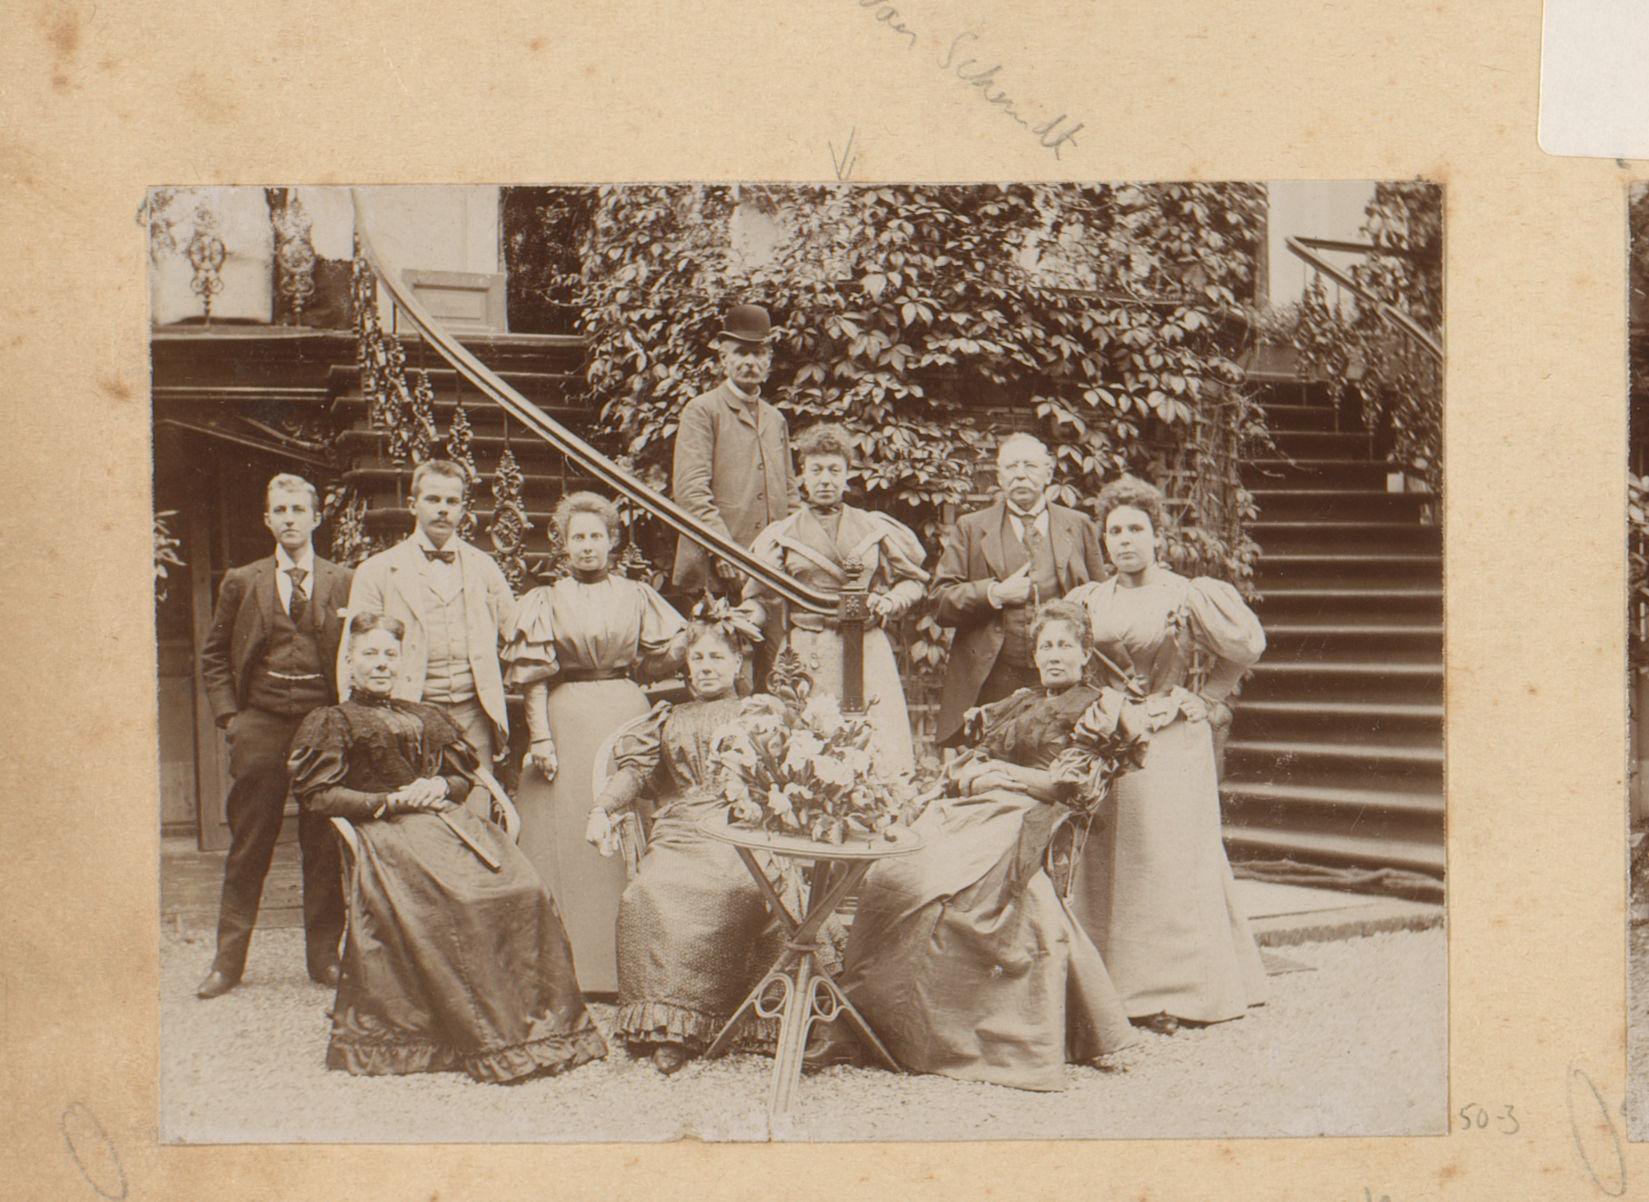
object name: photograph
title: Groepsportret in de tuin op de verjaardag van Carolina Frederika Holle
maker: hendrik herman van den berg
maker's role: amateurfotograaf, jurist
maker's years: 1875-1944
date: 1894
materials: paper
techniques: collodion silver print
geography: amsterdam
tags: norbertus petrus van den berg (1831-1917), batavia, carolina frederika van den berg-holle, historical persons, family life, amsterdam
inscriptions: caption: ‘Jet van Schmidt’, caption: ‘4 juni 1894/ verjaardag C.F. vd B-H’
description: Foto 3 op albumblad 50 uit album "Amsterdam 1890-1894".